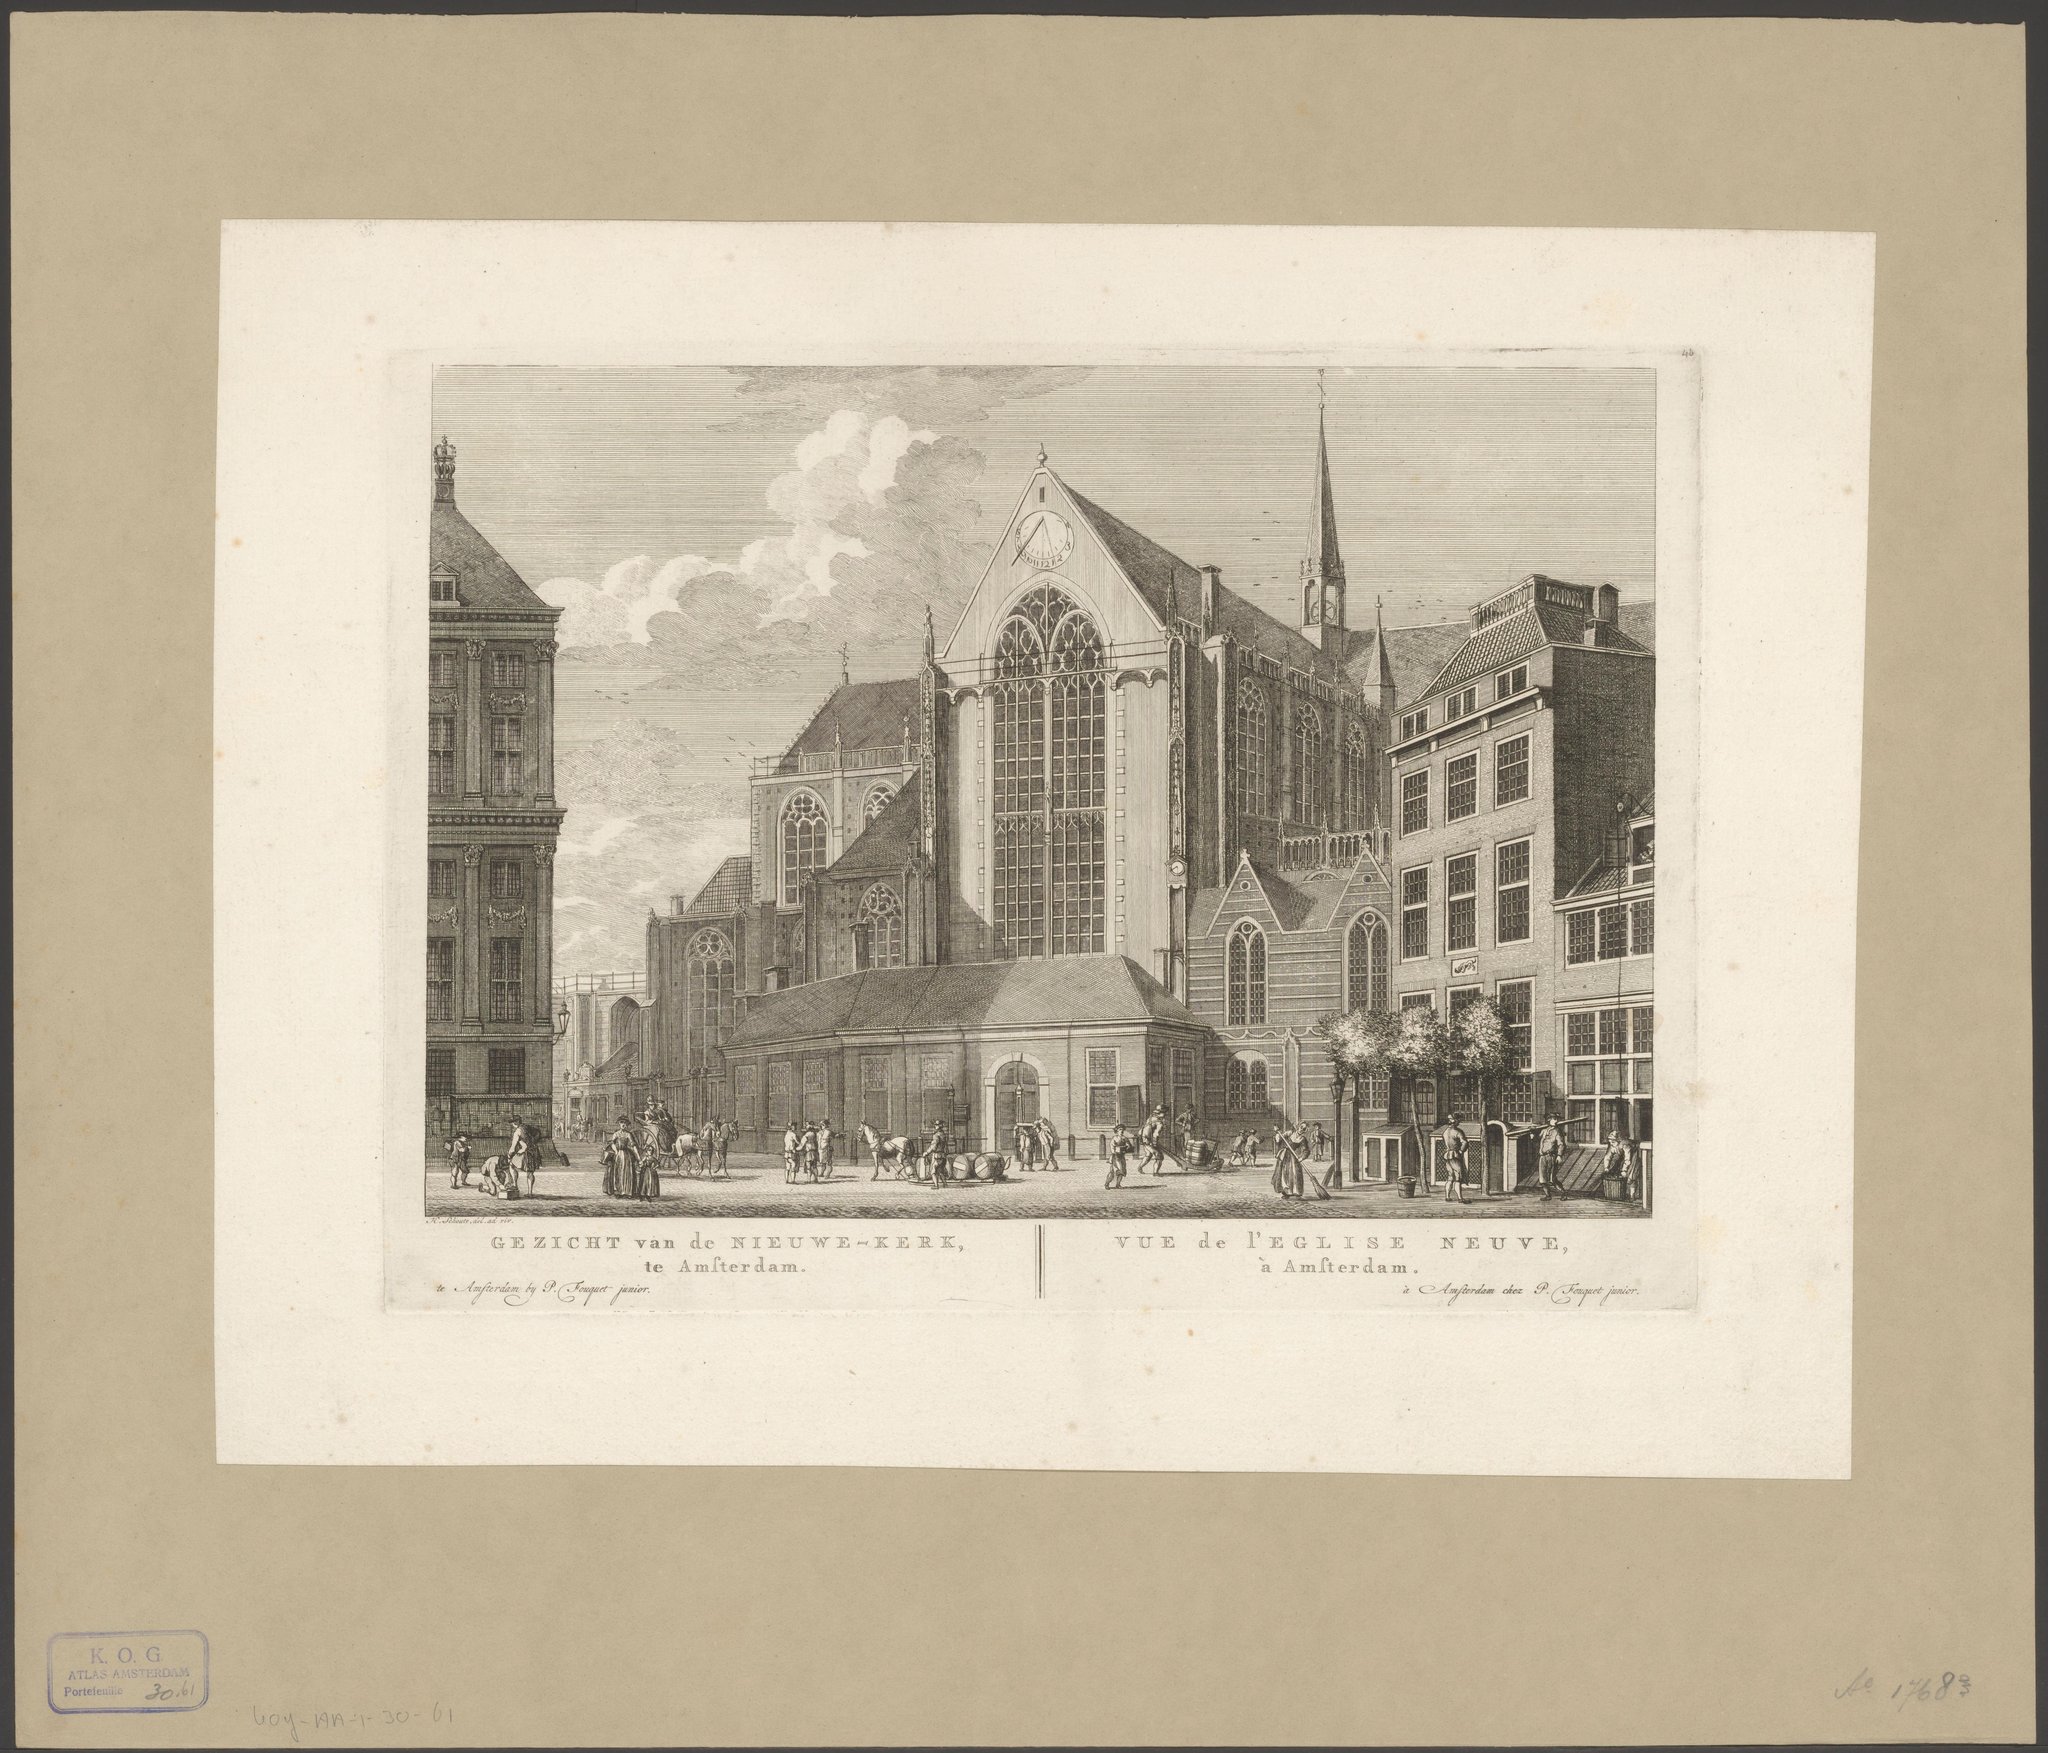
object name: print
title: Gezicht van de Nieuwe-Kerk, te Amsterdam / Vue de l'Eglise Neuve, à Amsterdam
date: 1770-1783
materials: paper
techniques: engraving, etching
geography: amsterdam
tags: church (exterior), square, place, circus, etc. (+ city(-scape) with figures, staffage)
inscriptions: collector's mark: Lugt 1641b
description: Vanaf 1760 gaf Pierre Fouquet stadsgezichten van Amsterdam naar tekeningen van verschillende kunstenaars uit. Deze prenten werden aanvankelijk los verkocht. Later werden ze samengebonden verkocht in verschillende volgordes en aantallen in: (1). Afbeeldingen van de wyd-vermaarde koopstad Amsterdam benevens des zelvs voornaamste gebouwen en gezigten alle naar het leeven getekend / Receuil des edifices les plus considerables et des plus belles vues, de la fameuse ville d'Amsterdam, dessinées d'après nature. Amsterdam: Pierre Fouquet, 1778-1783. Deze 'uitgave' bestond waarschijnlijk alleen uit een titelblad en inhoudsopgave van de tot dusver 100 uitgegeven prenten, die de koper zelf aan zijn of haar reeds verzamelde prenten kon toevoegen. De hoeveelheid en volgorde van prenten verzameld onder deze titel verschilt dus sterk. (2). Nieuwe atlas, van de voornaamste gebouwen en gezigten der stad Amsterdam, met derzelver beknopte beschryvingen. 2 dln. Amsterdam: Daniël Jean Changuion en Petrus den Hengst [in opdracht van Pierre Fouquet], 1783. Ook werden er door verschillende uitgevers tussen 1788 (Amsterdam: Petrus Conradi) en 1805 (Amsterdam: Evert Maaskamp) heruitgaven gepubliceerd.